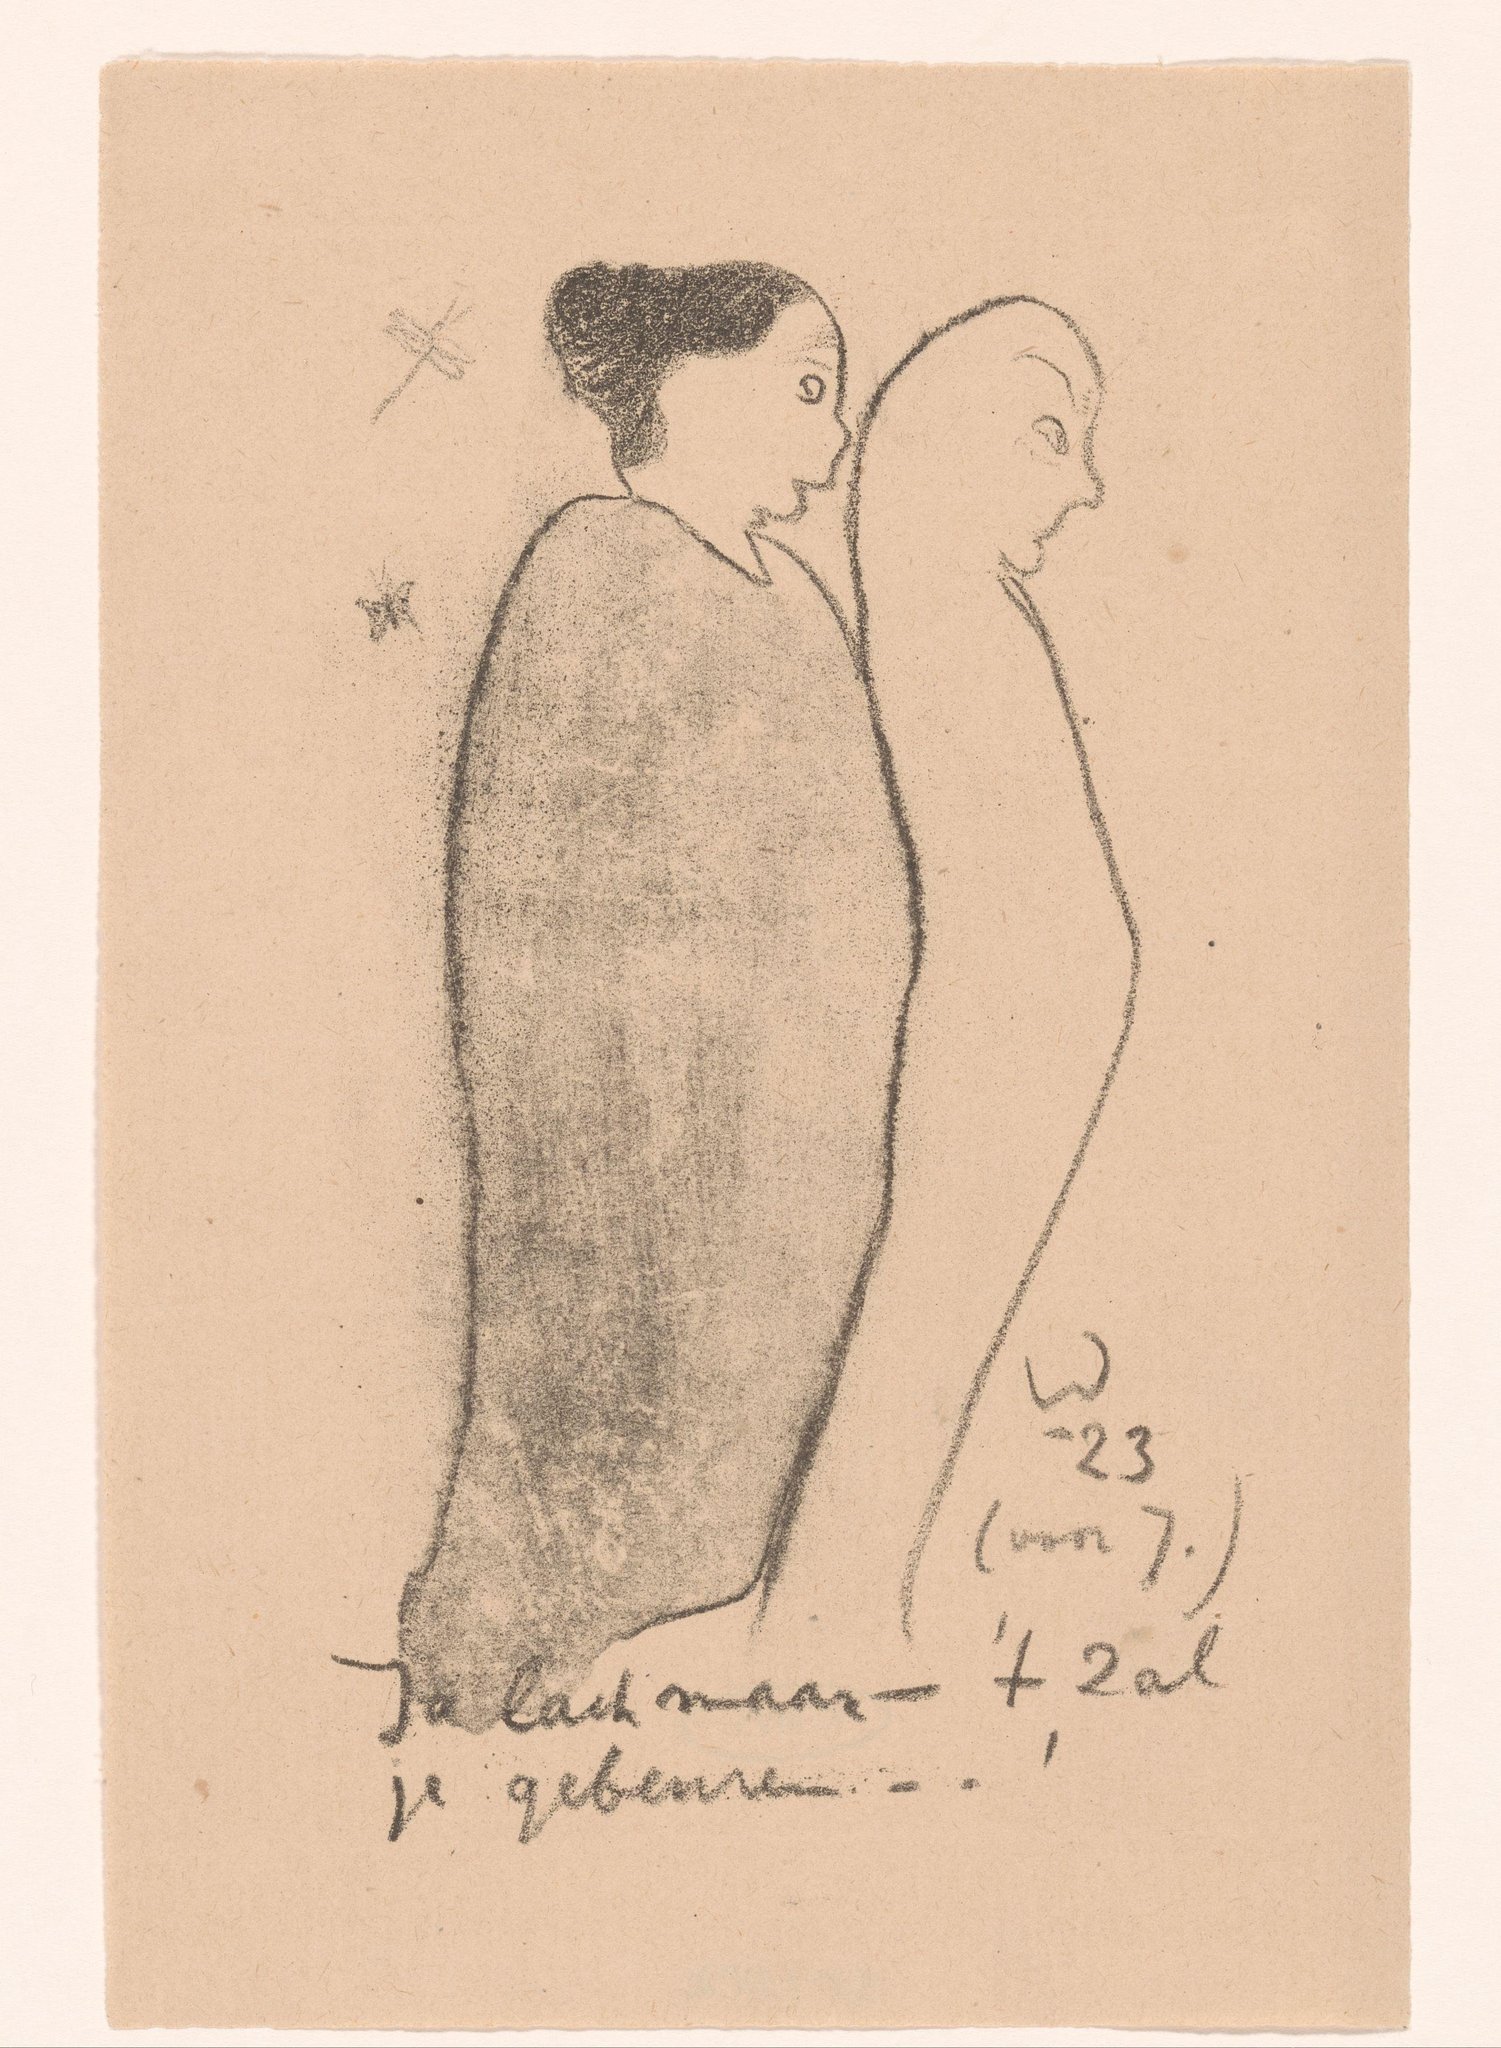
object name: print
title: Twee staande figuren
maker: erich wichmann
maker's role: print maker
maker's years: 1890-1929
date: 1923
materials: paper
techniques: lithograph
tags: caricatures (human types), insects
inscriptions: collector's mark: Lugt 2228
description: Links een libelle en een vlinder. Onderaan de tekst: 'Ja lach maar - 't zal je gebeuren..!'